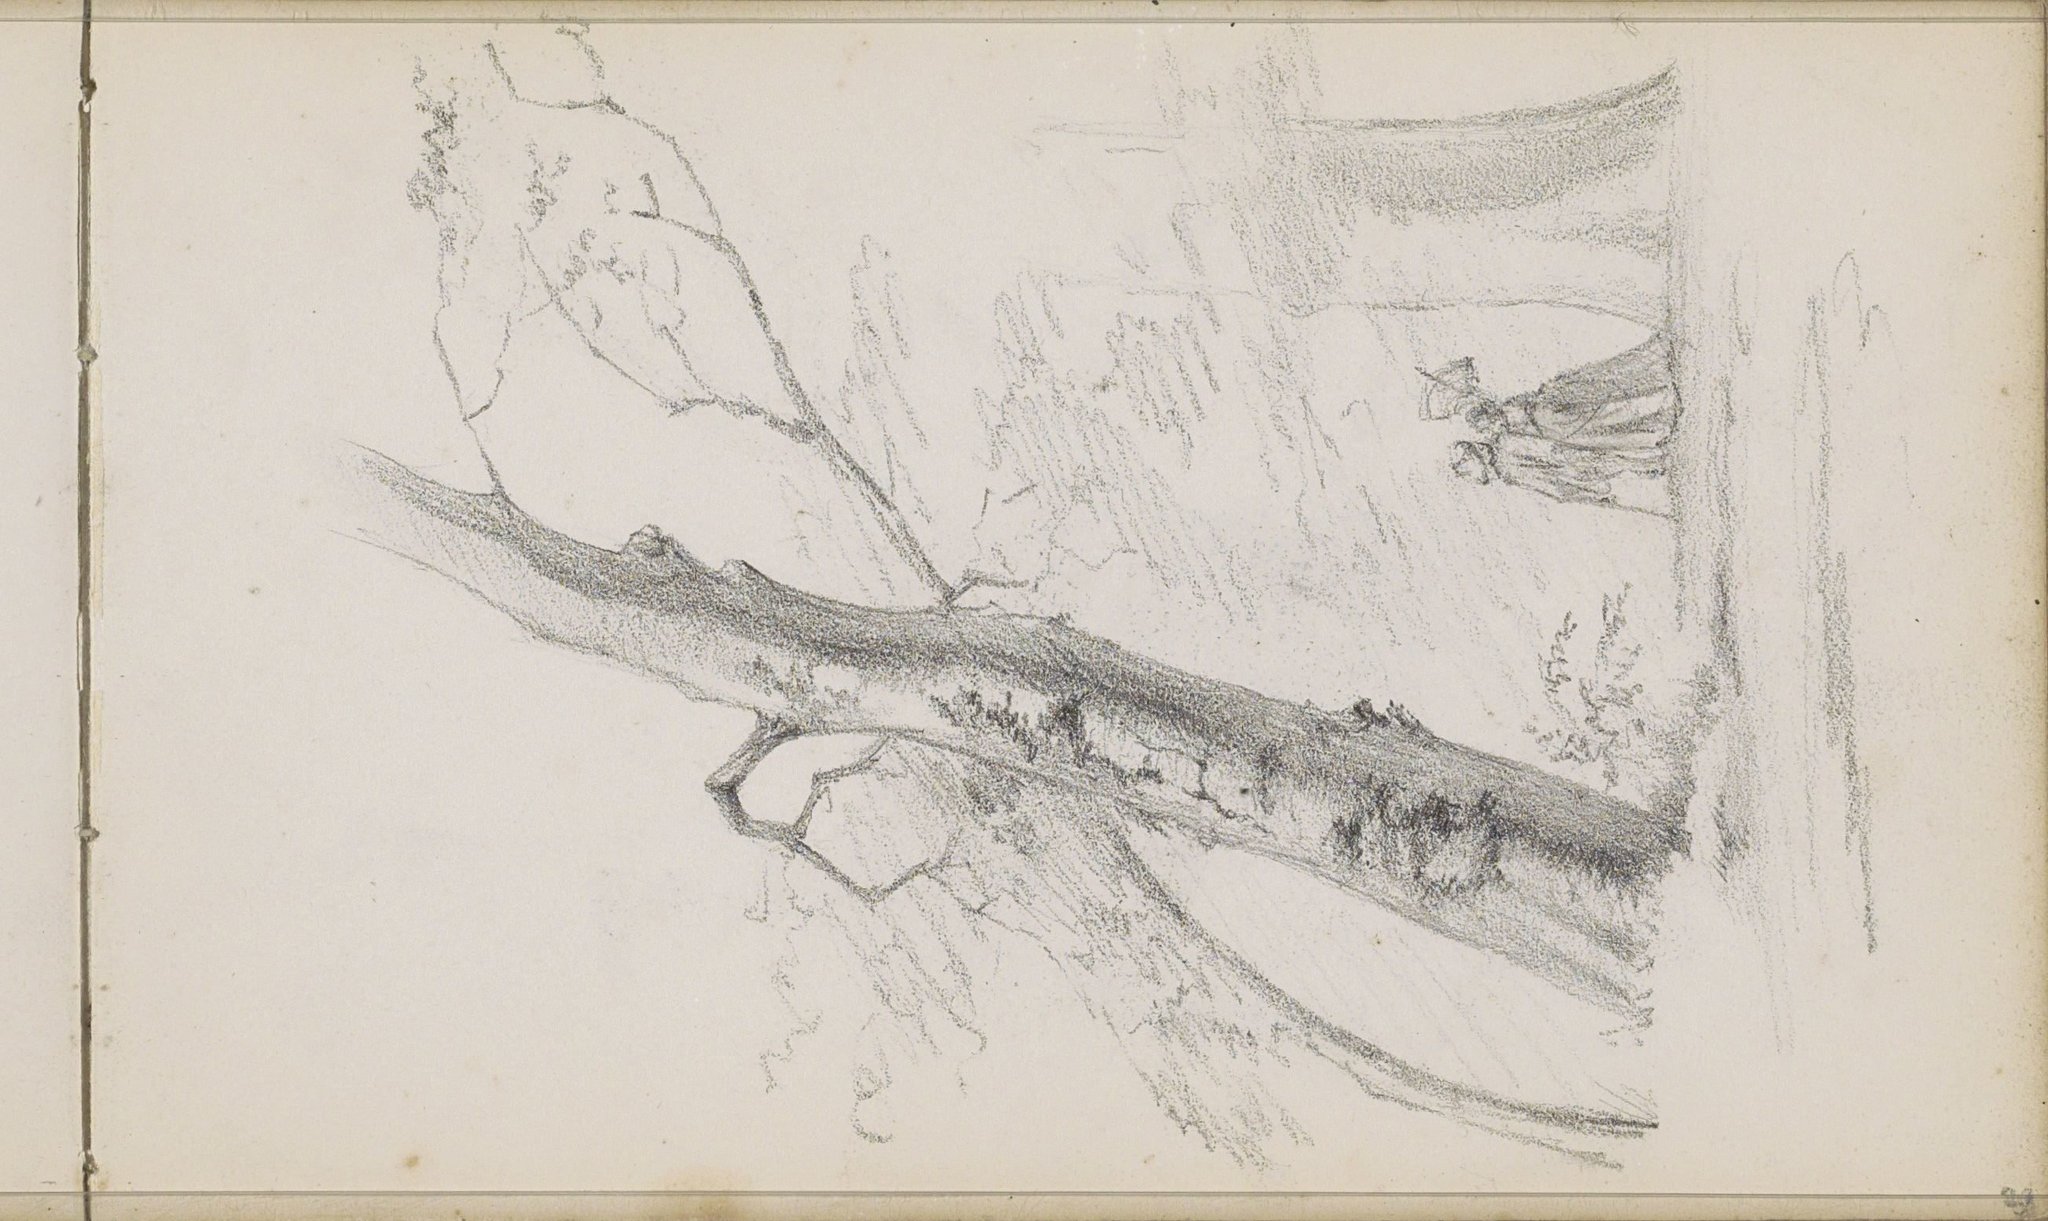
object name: sketchbook leaf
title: Wandelend paar op een bospad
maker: willem cornelis rip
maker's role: draughtsman, painter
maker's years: 1856-1922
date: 1874-1875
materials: paper, pencil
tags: forest path or lane (+ landscape with figures, staffage)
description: De man draagt een wandelstok en de vrouw een parasol. Blad 29 recto uit een schetsboek met 46 bladen.